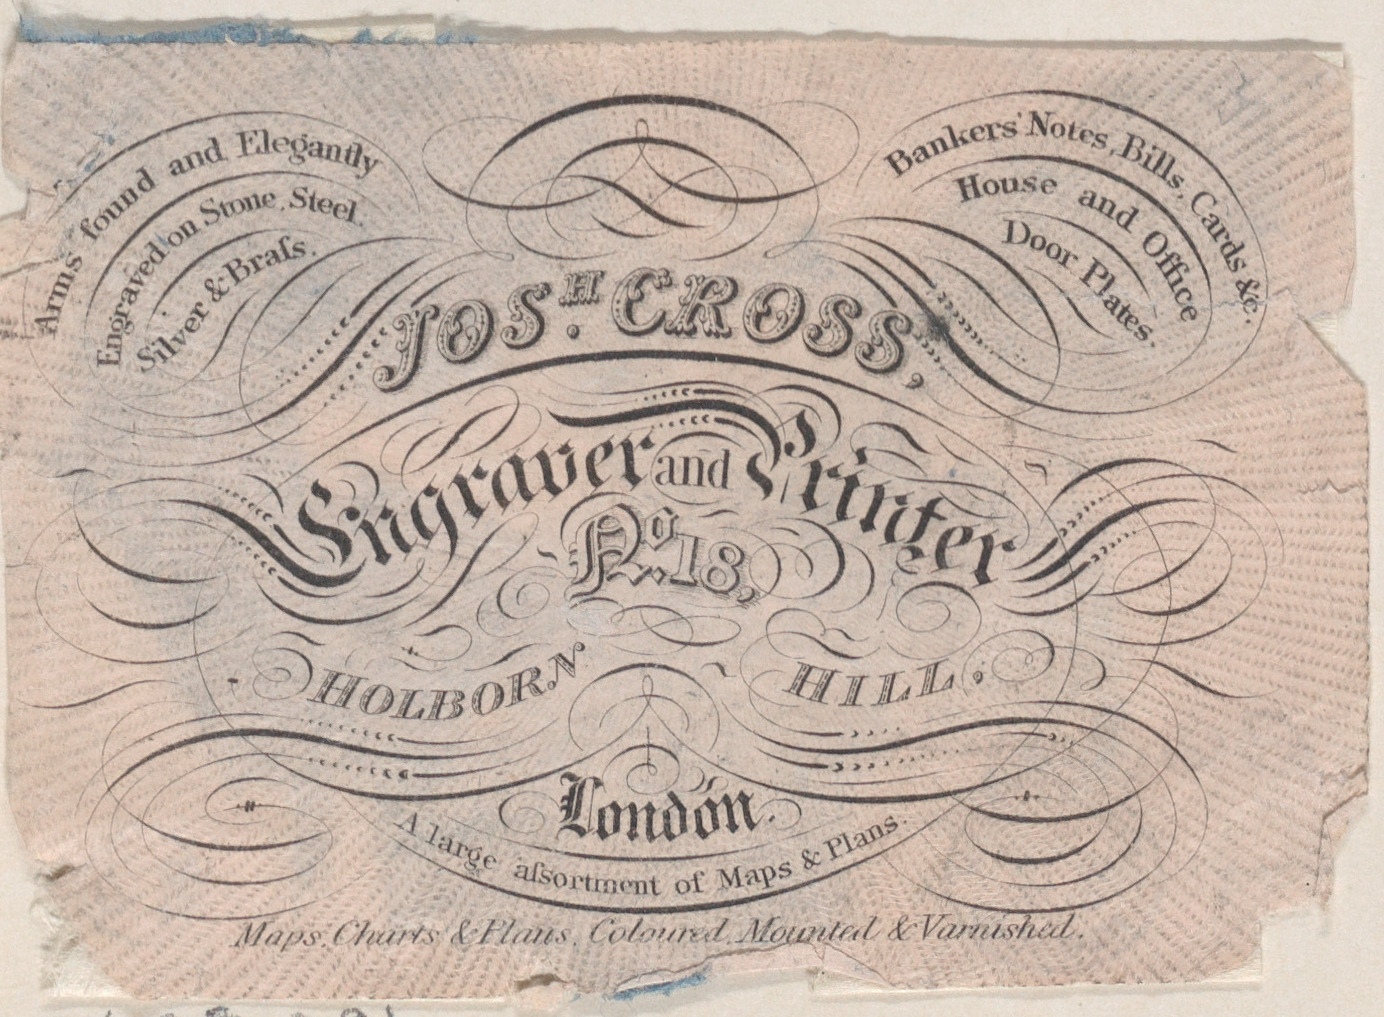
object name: print, trade card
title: Trade Card for Josh Cross, Engraver & Printer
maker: anonymous, british, 19th century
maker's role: artist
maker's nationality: british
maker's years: 1800-1900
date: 1801-1900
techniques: engraving